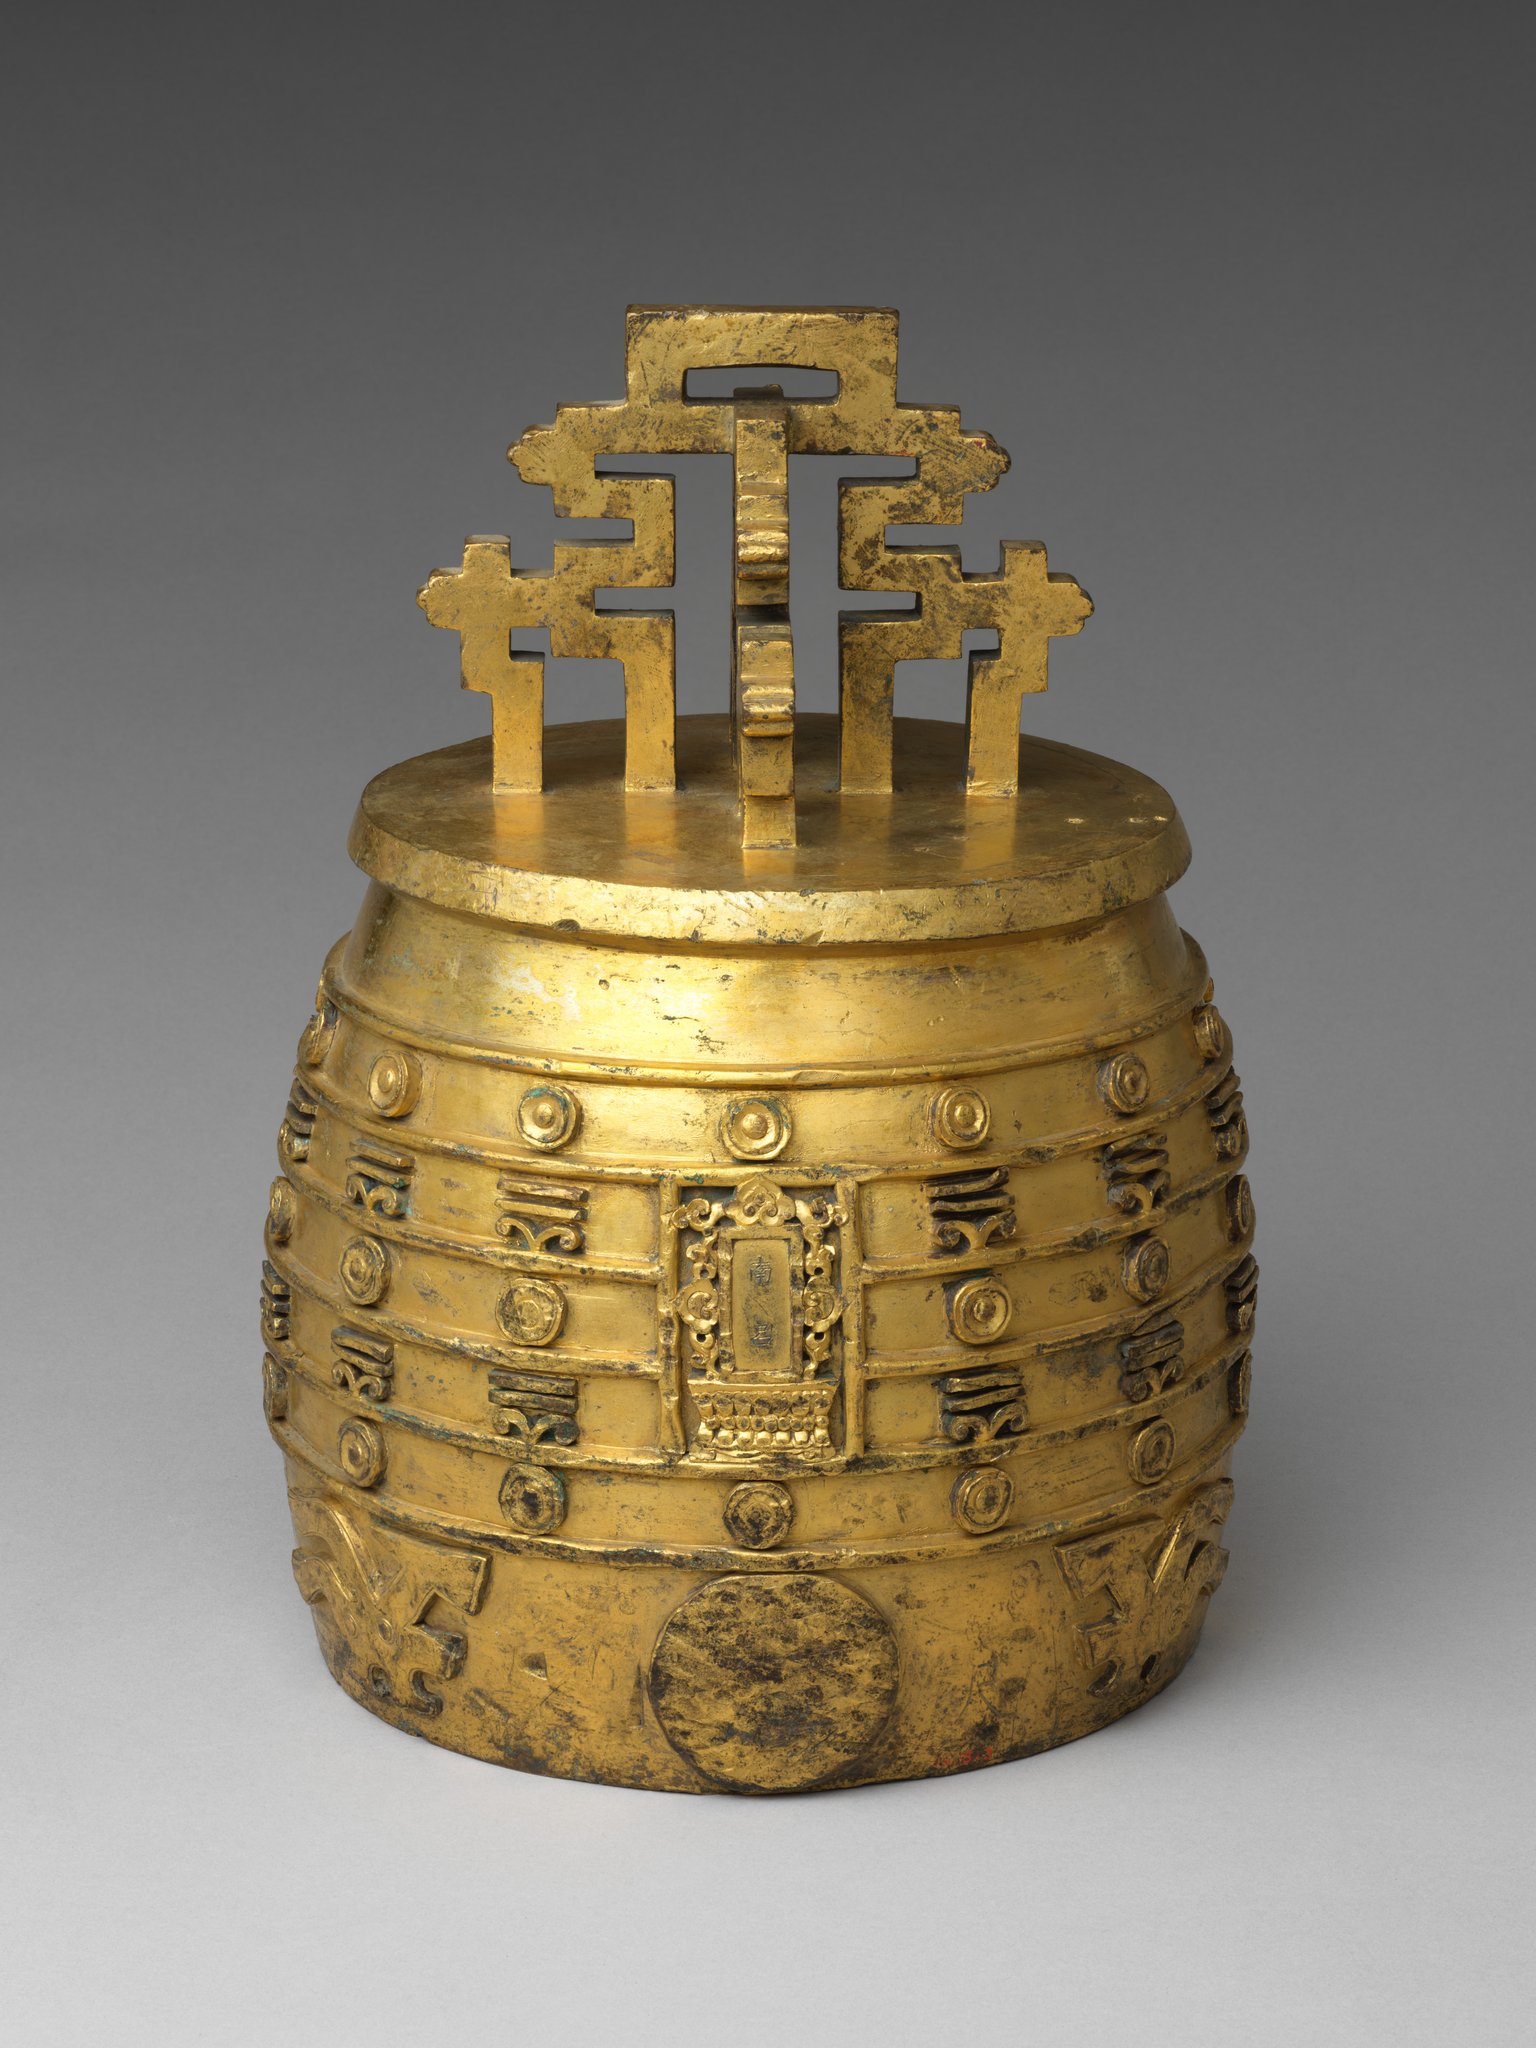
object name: bell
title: Ritual bell, note nanlü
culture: chinese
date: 1745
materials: copper alloy, gilt